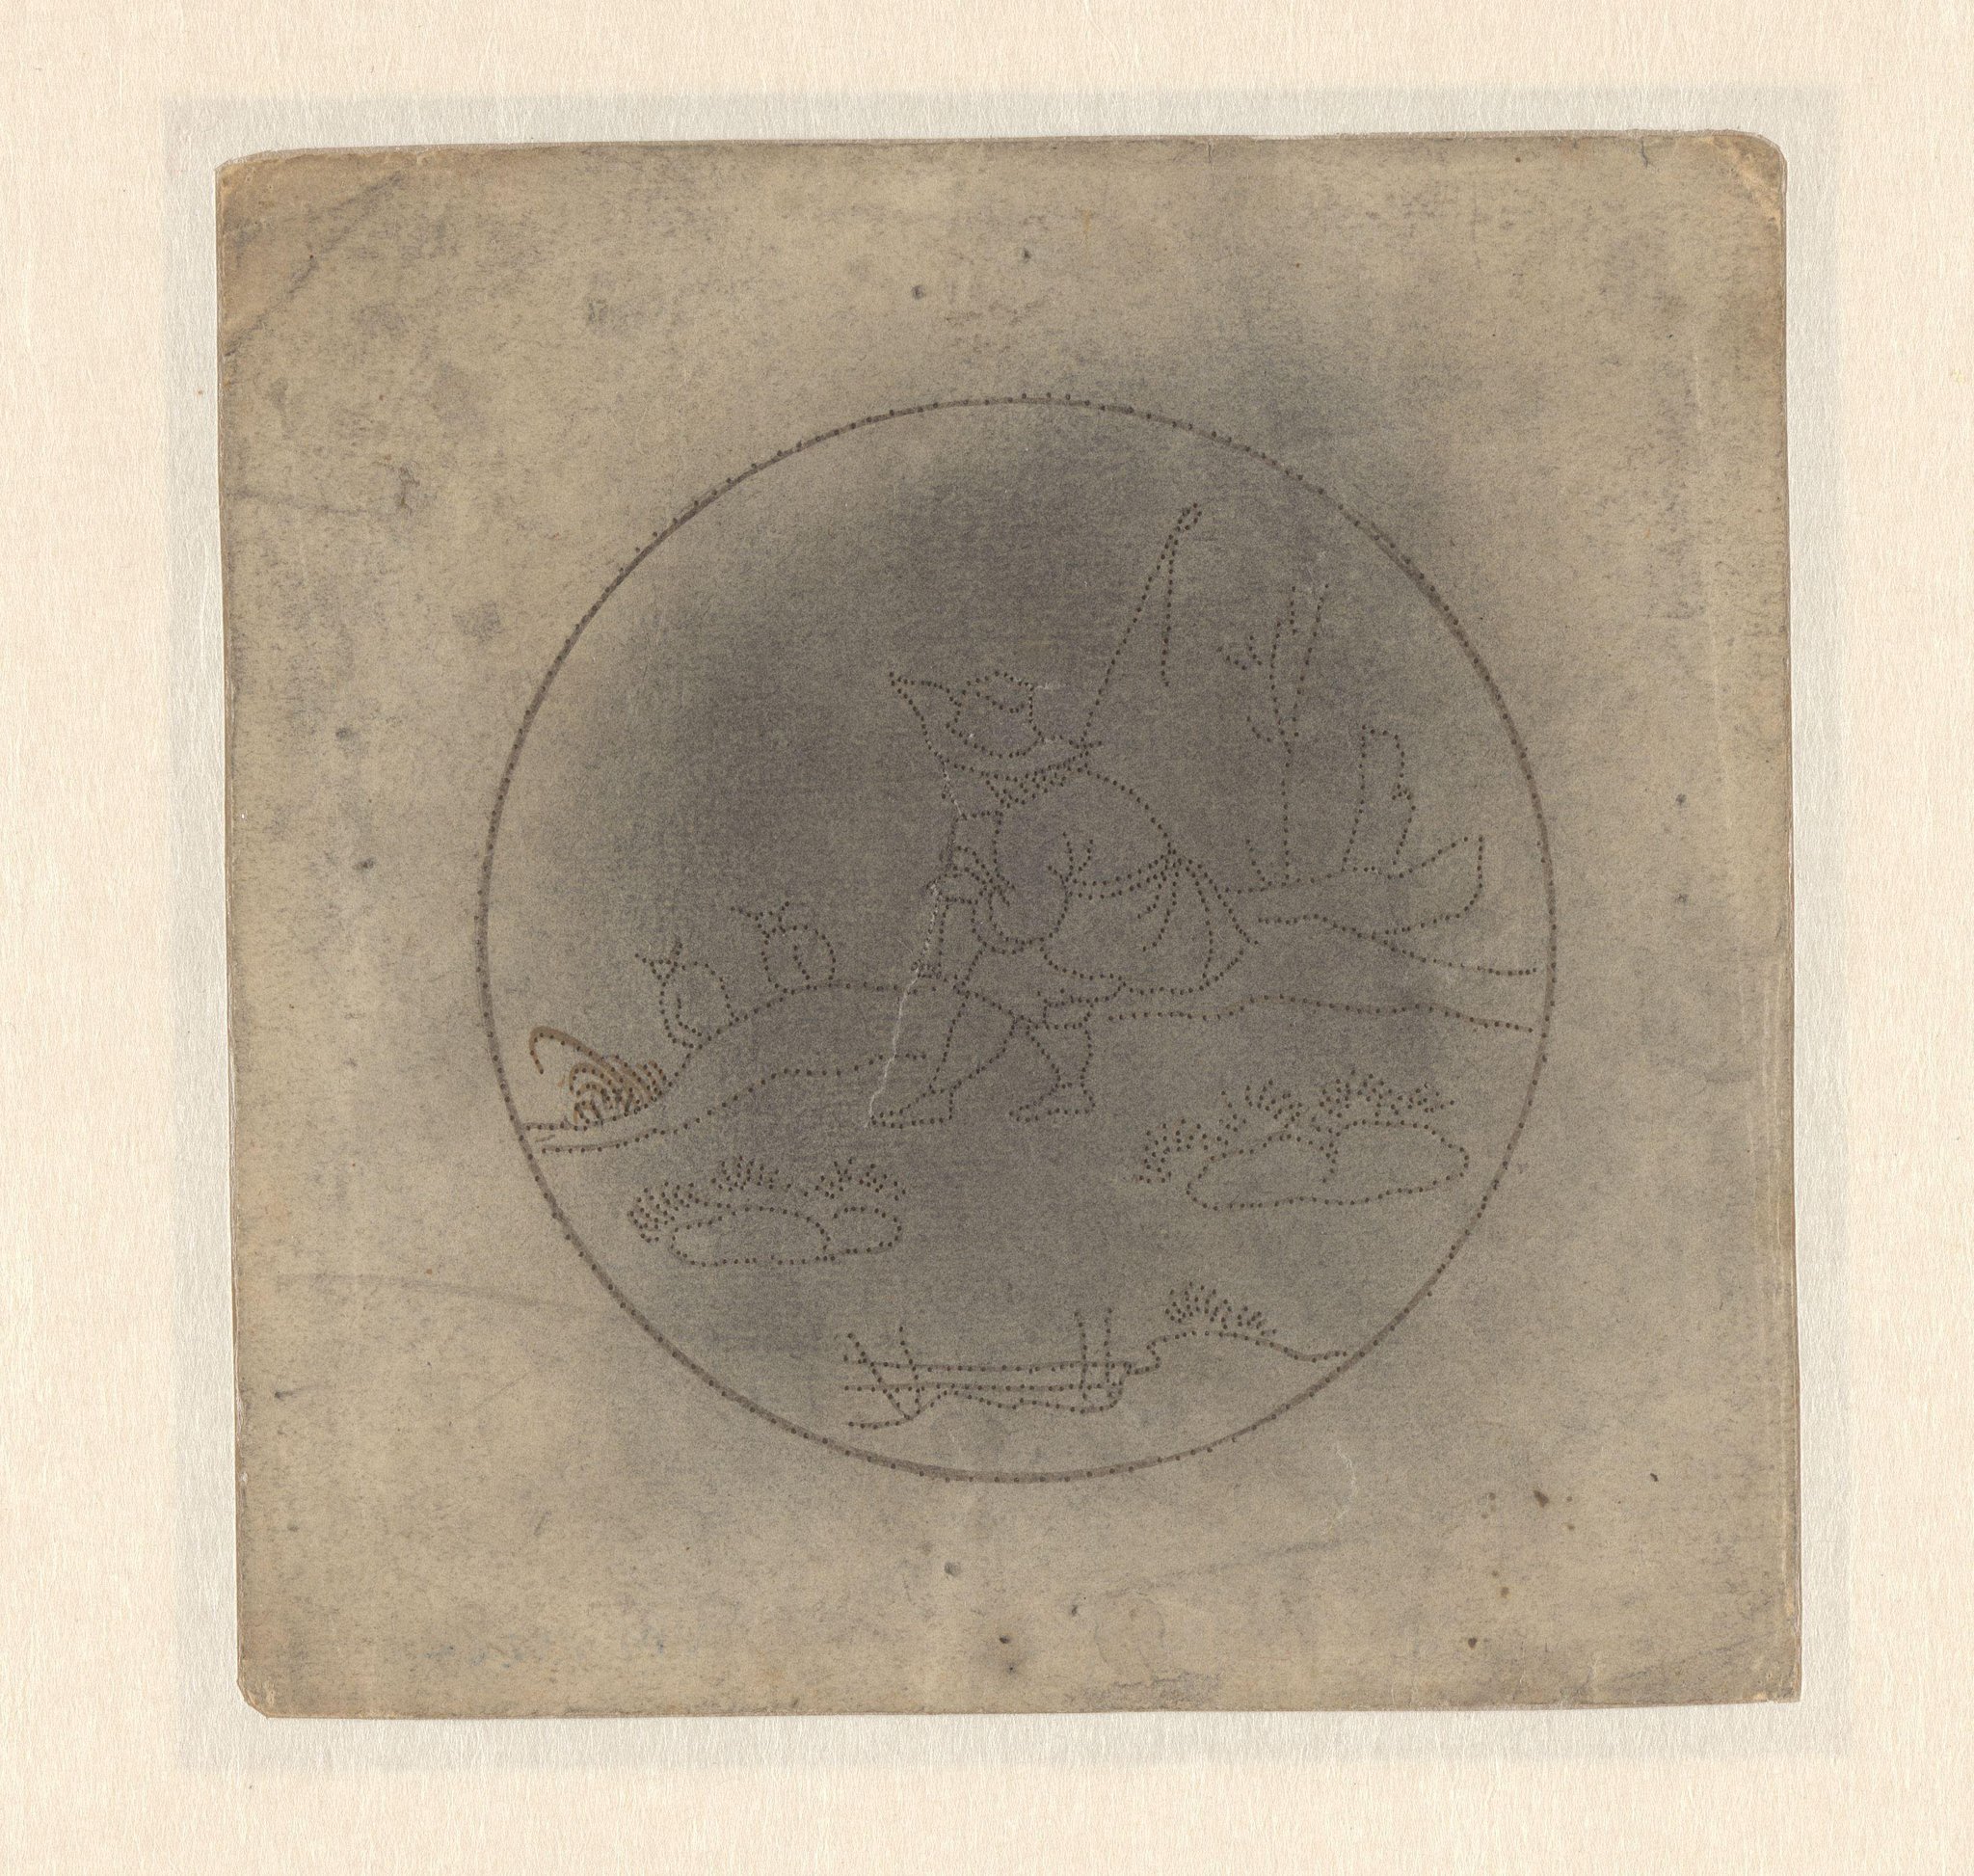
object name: punchwork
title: Pons of spons: op papier geponste voorstelling van een herder ten behoeve van tegelfabricage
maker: Anonymous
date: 1700-1800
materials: paper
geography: netherlands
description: Pons of spons: op papier geponste voorstelling van een herder ten behoeve van tegelfabricage.